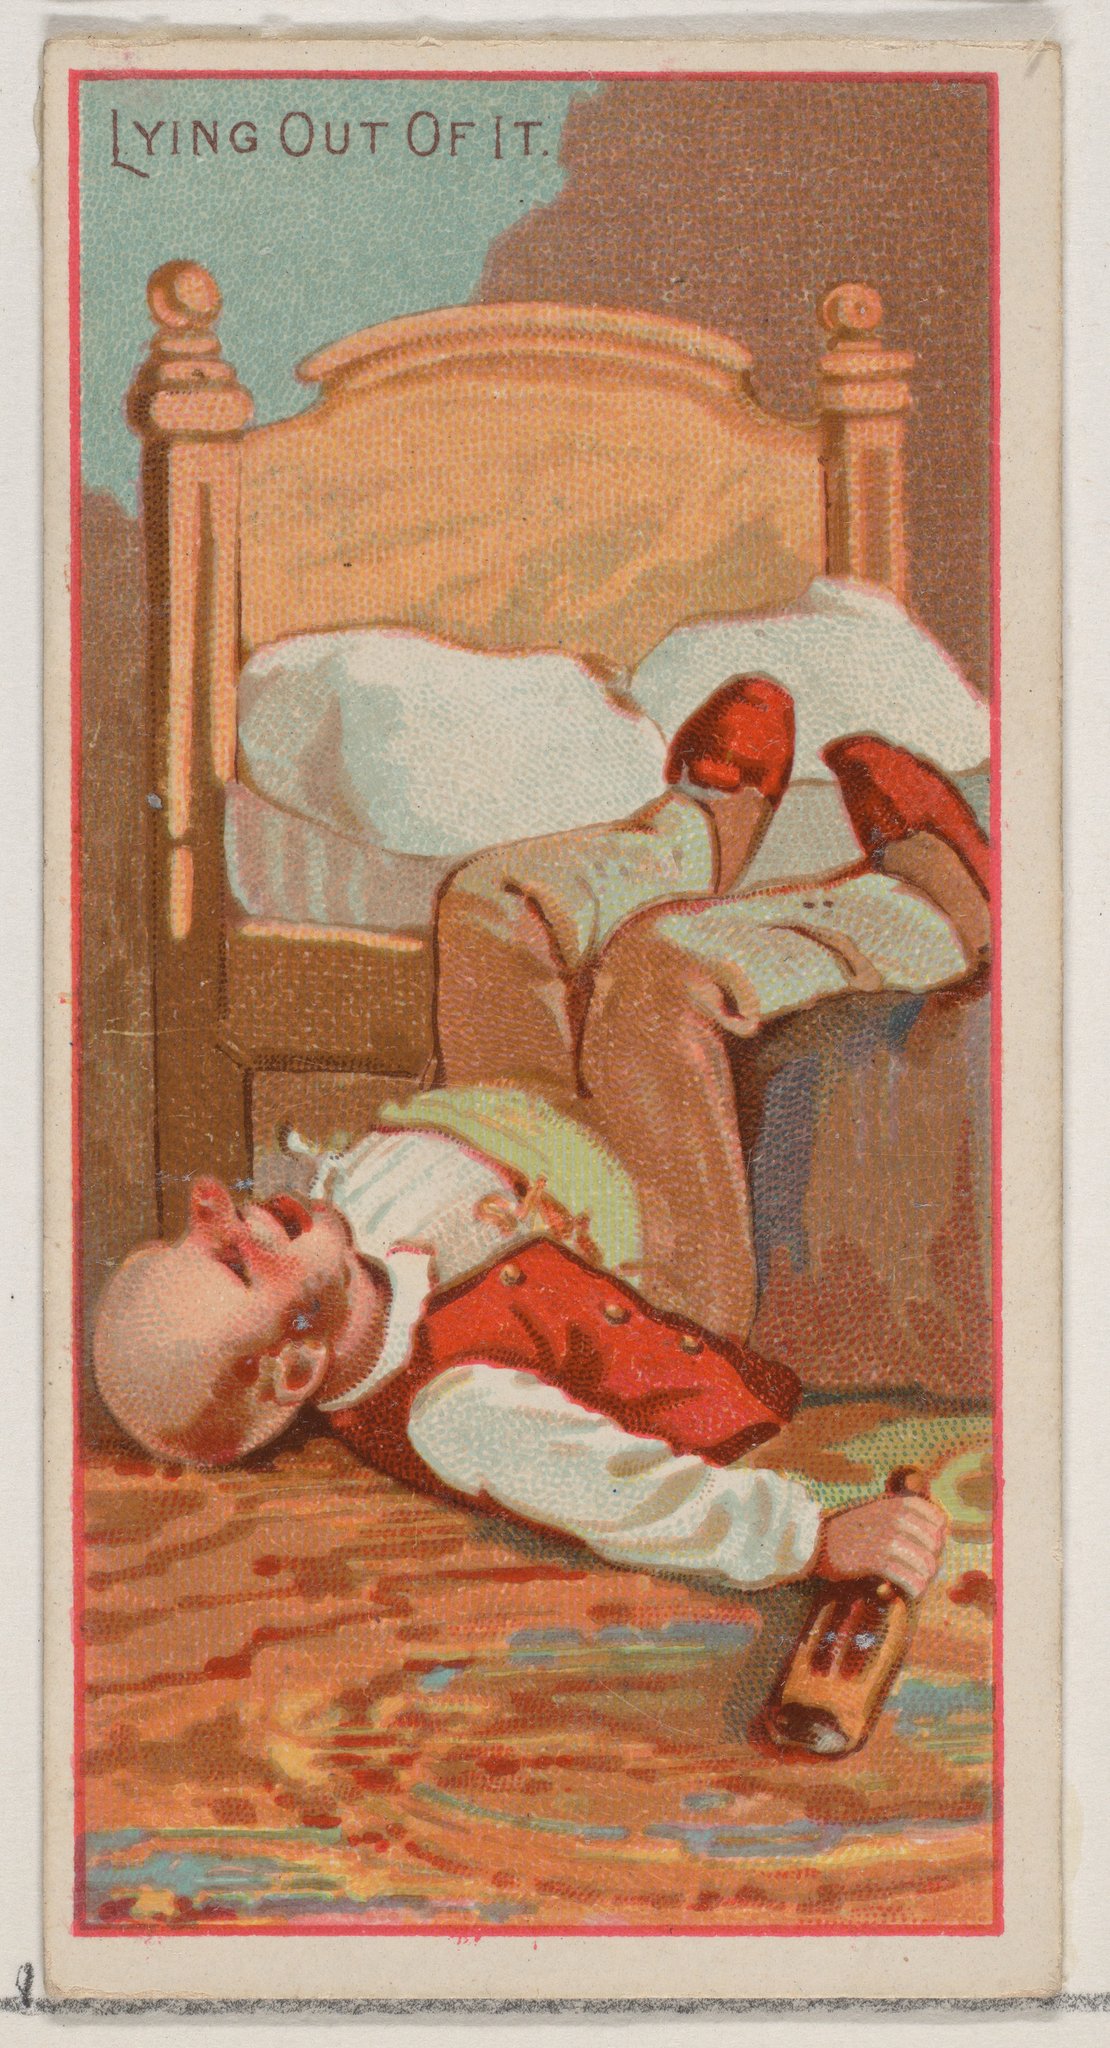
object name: print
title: Lying Out of It, from the Jokes series (N87) for Duke brand cigarettes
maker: w. duke, sons & co.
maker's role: publisher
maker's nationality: american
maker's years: 1870-1920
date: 1890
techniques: color lithograph